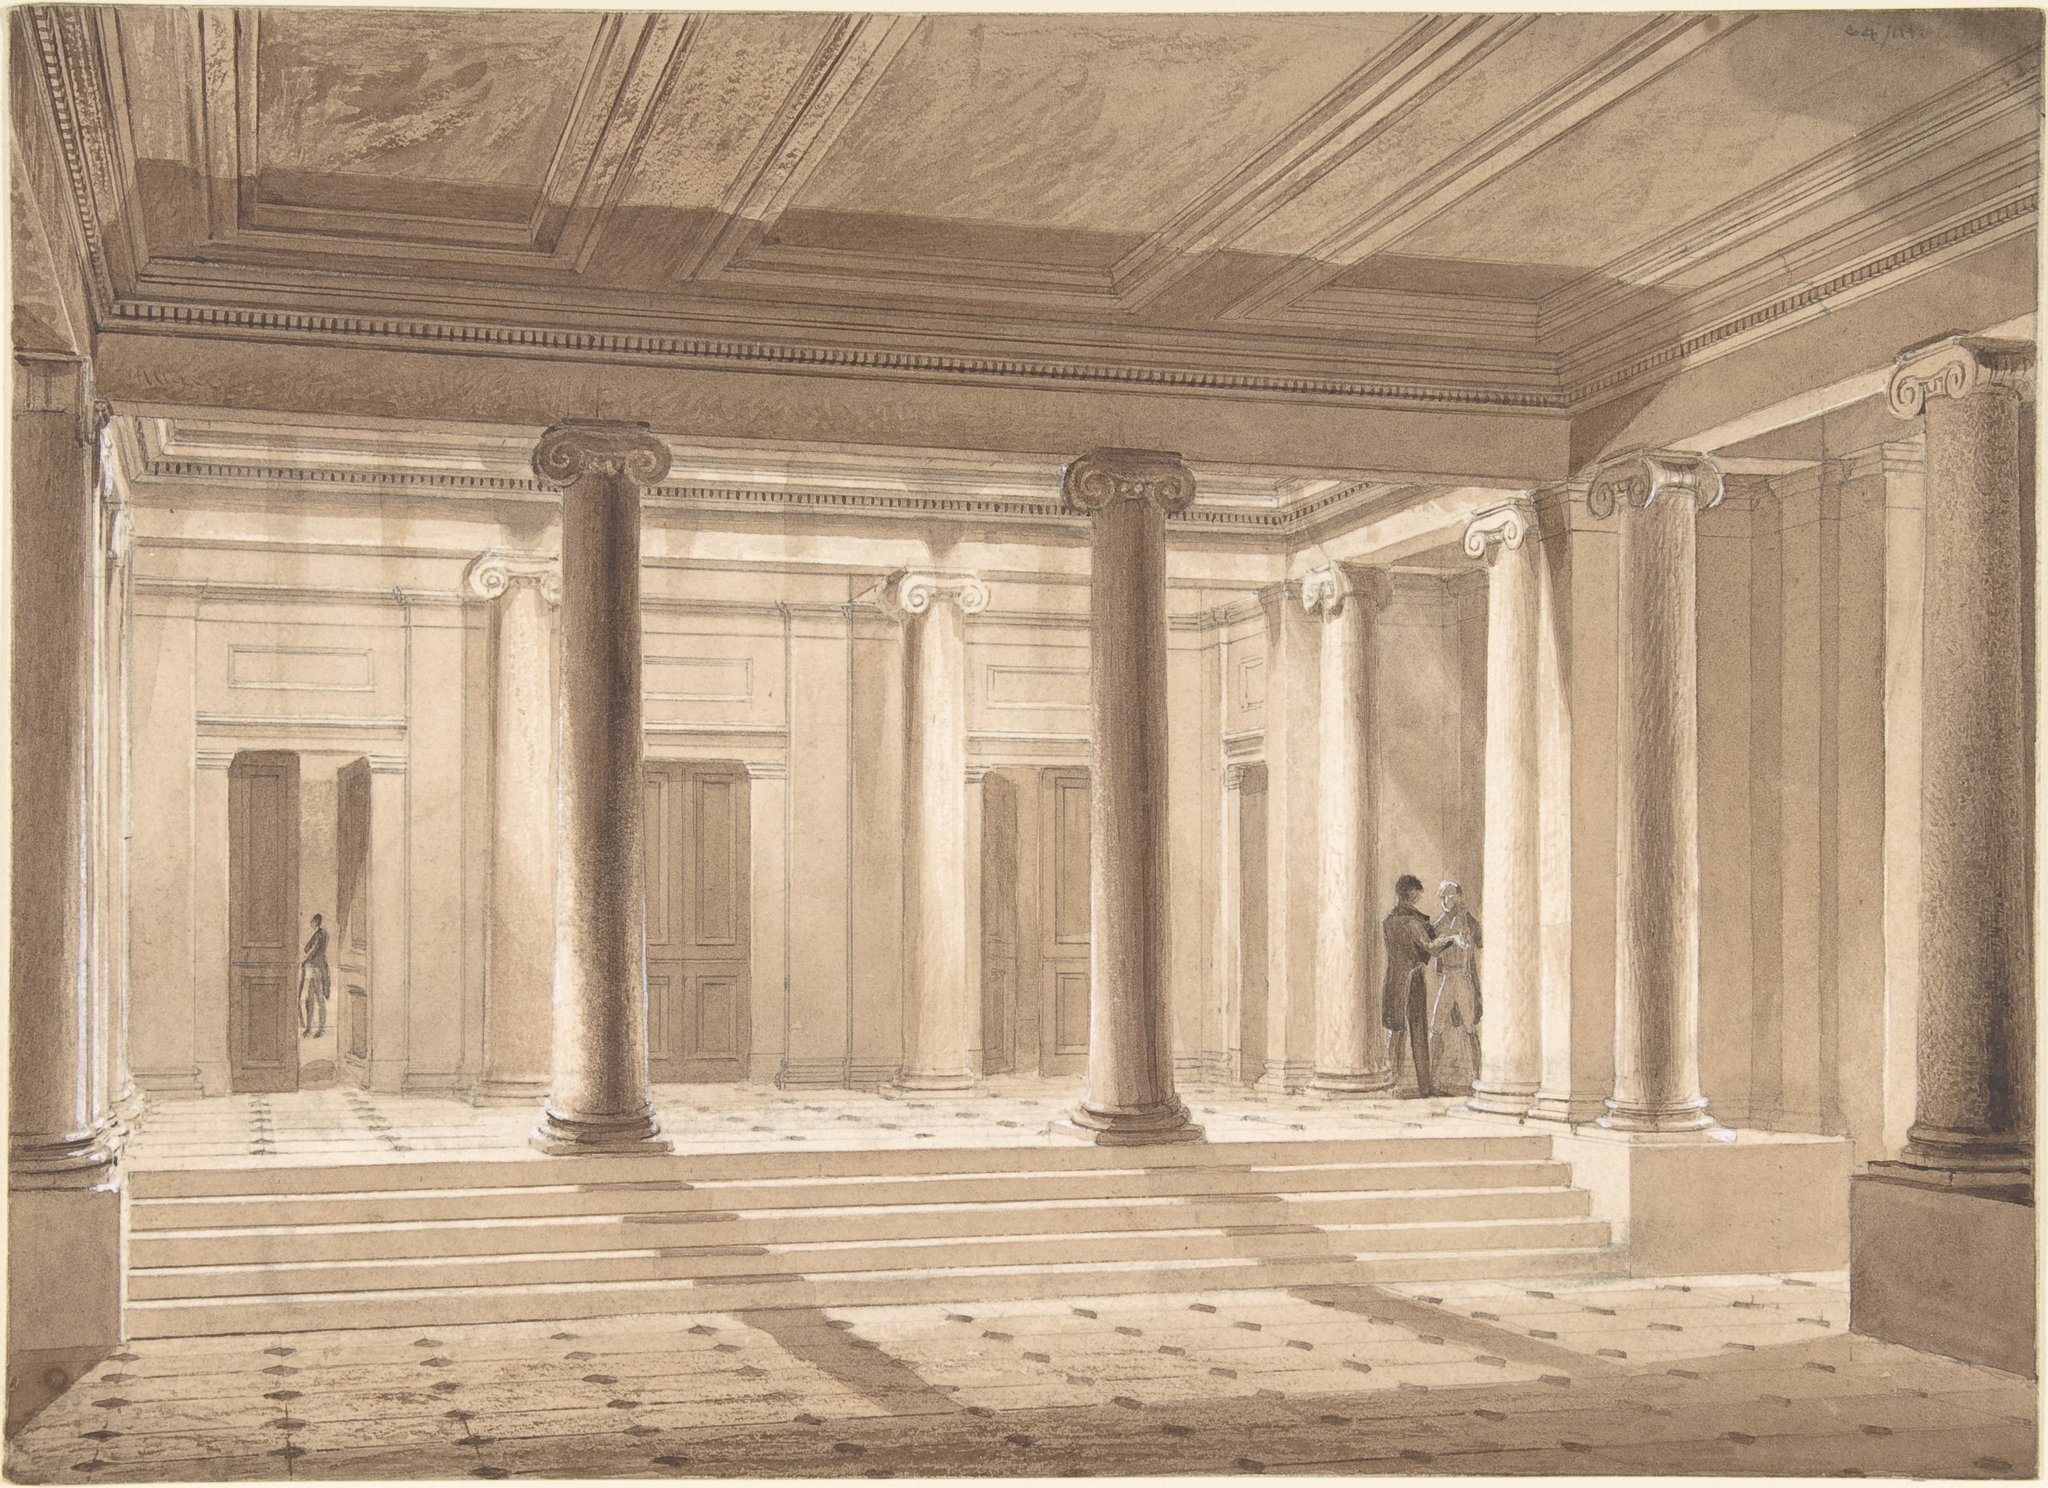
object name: drawing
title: Ionic Entrance Hall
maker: anonymous, british, 19th century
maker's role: artist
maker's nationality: british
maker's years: 1800-1900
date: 1801-1900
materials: ink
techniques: brush, pen, wash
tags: columns,interiors